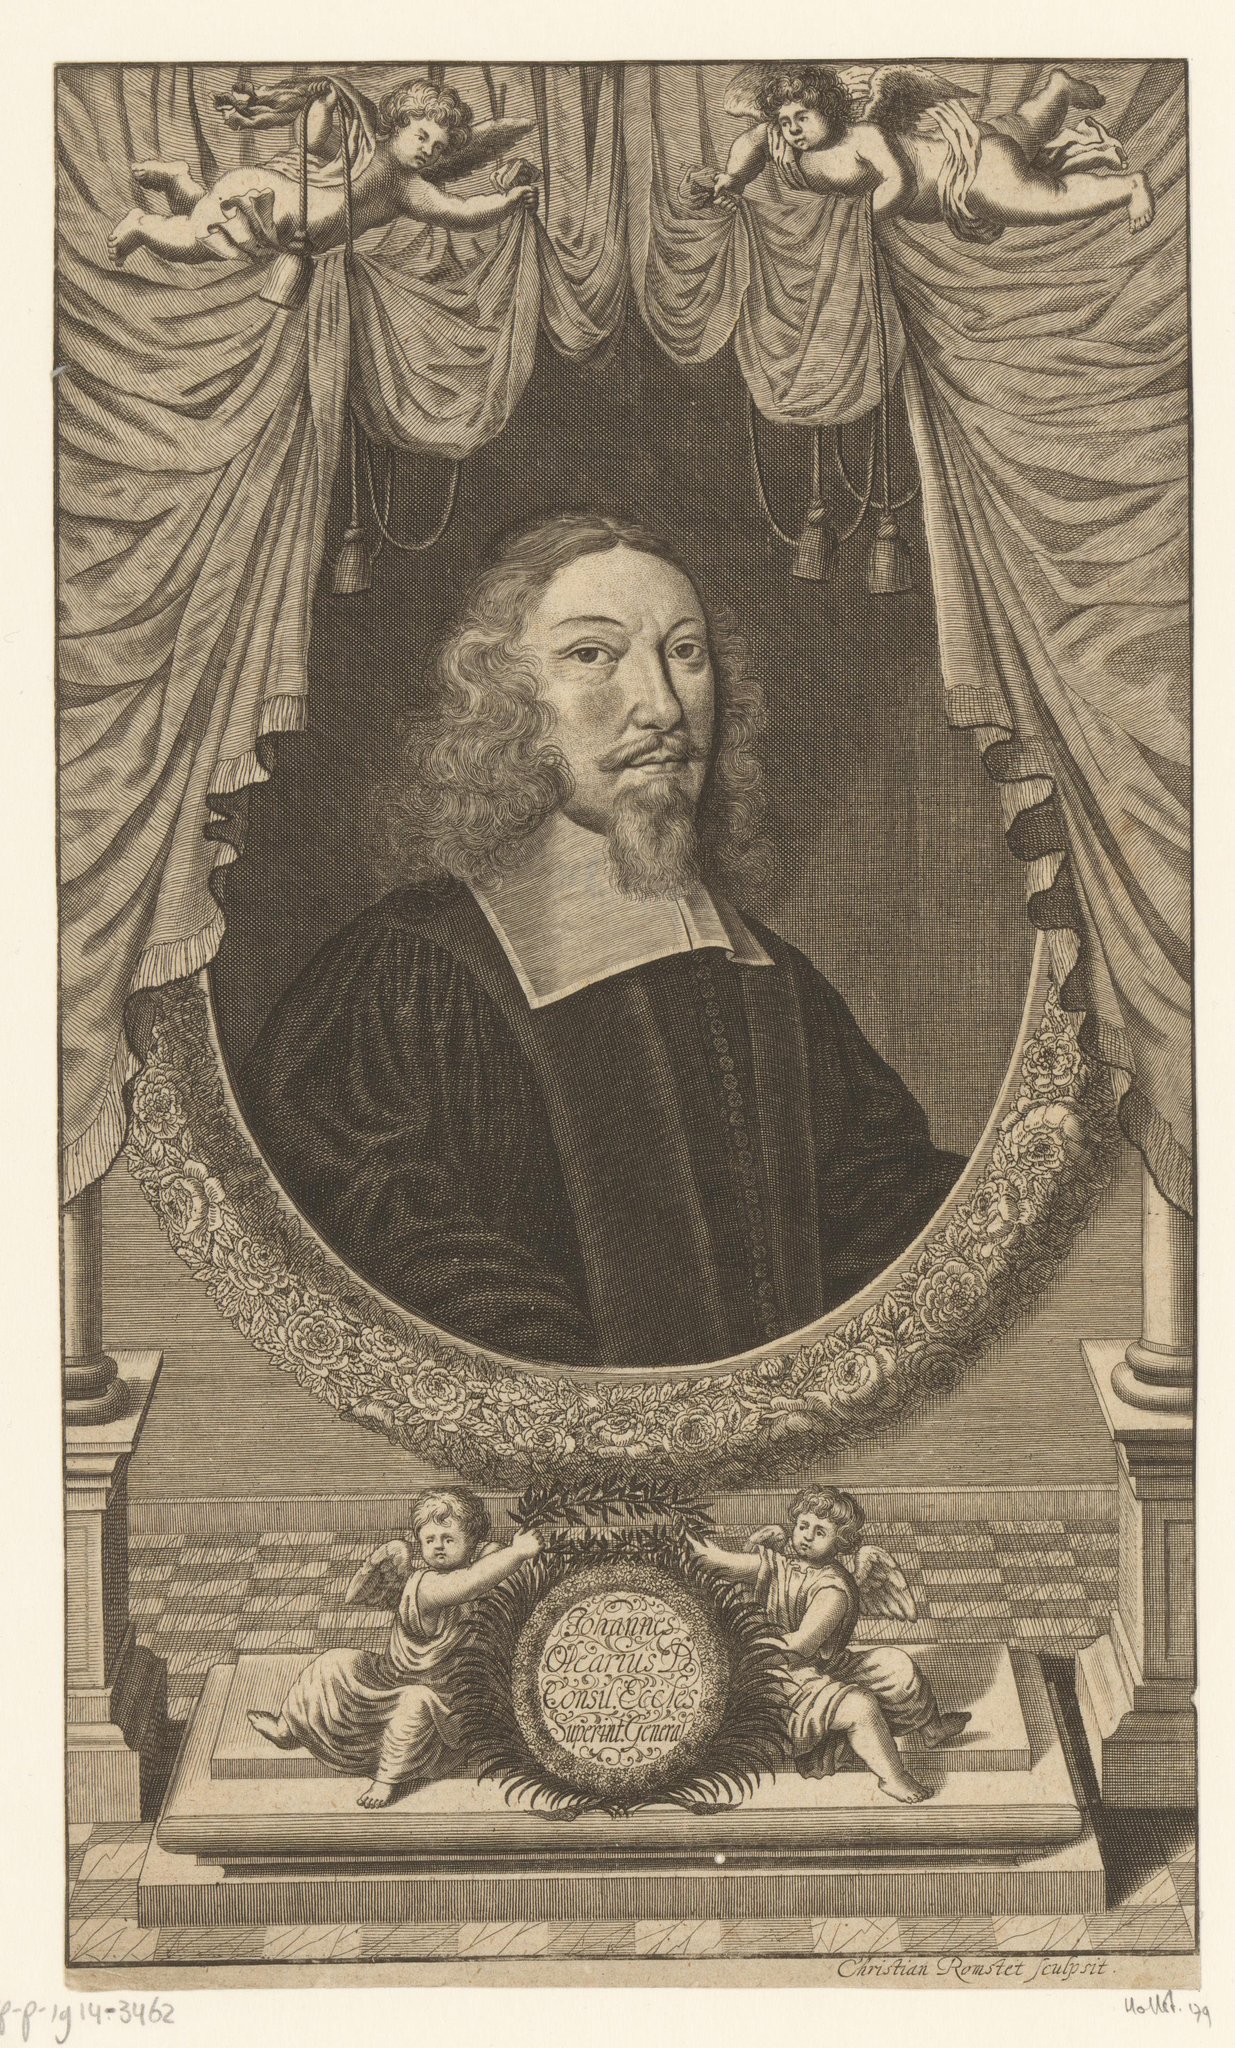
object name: print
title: Portret van Johannes Olearius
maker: christian romstet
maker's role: print maker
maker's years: 1640-1721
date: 1665-1721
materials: paper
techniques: engraving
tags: garland, wreath, historical persons, cupids: 'amores', 'amoretti', 'putti'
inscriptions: collector's mark: Lugt 2228